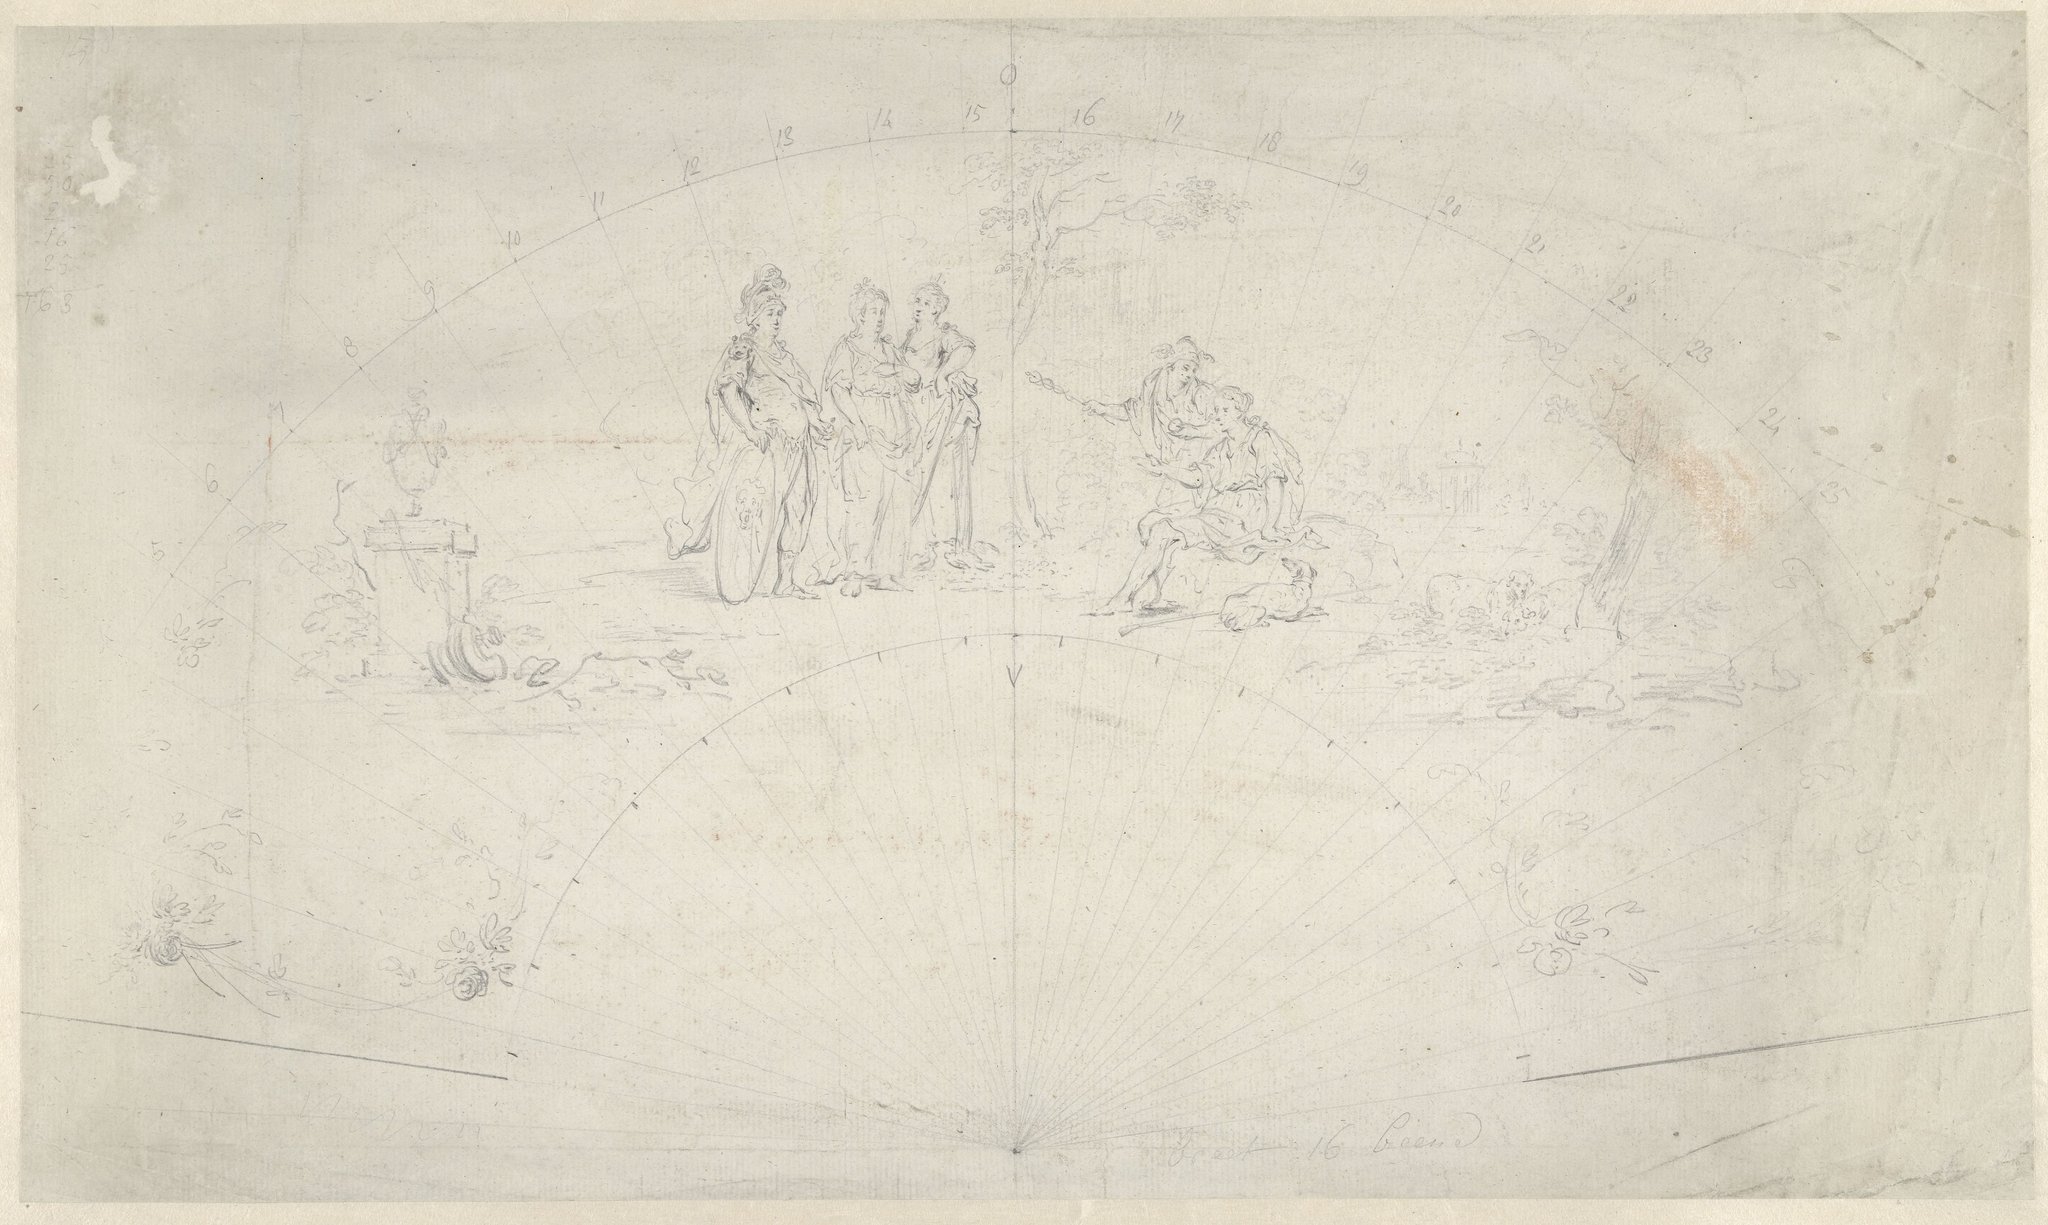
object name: design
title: Ontwerp voor een waaier met het oordeel van Paris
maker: Anonymous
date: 1700-1800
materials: paper, pencil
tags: the judgement of paris (mercury present)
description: Ontwerp voor een waaier met het oordeel van Paris, verdeeld in 31 genummerde vakken. Opschrift: Breet 16 beene.